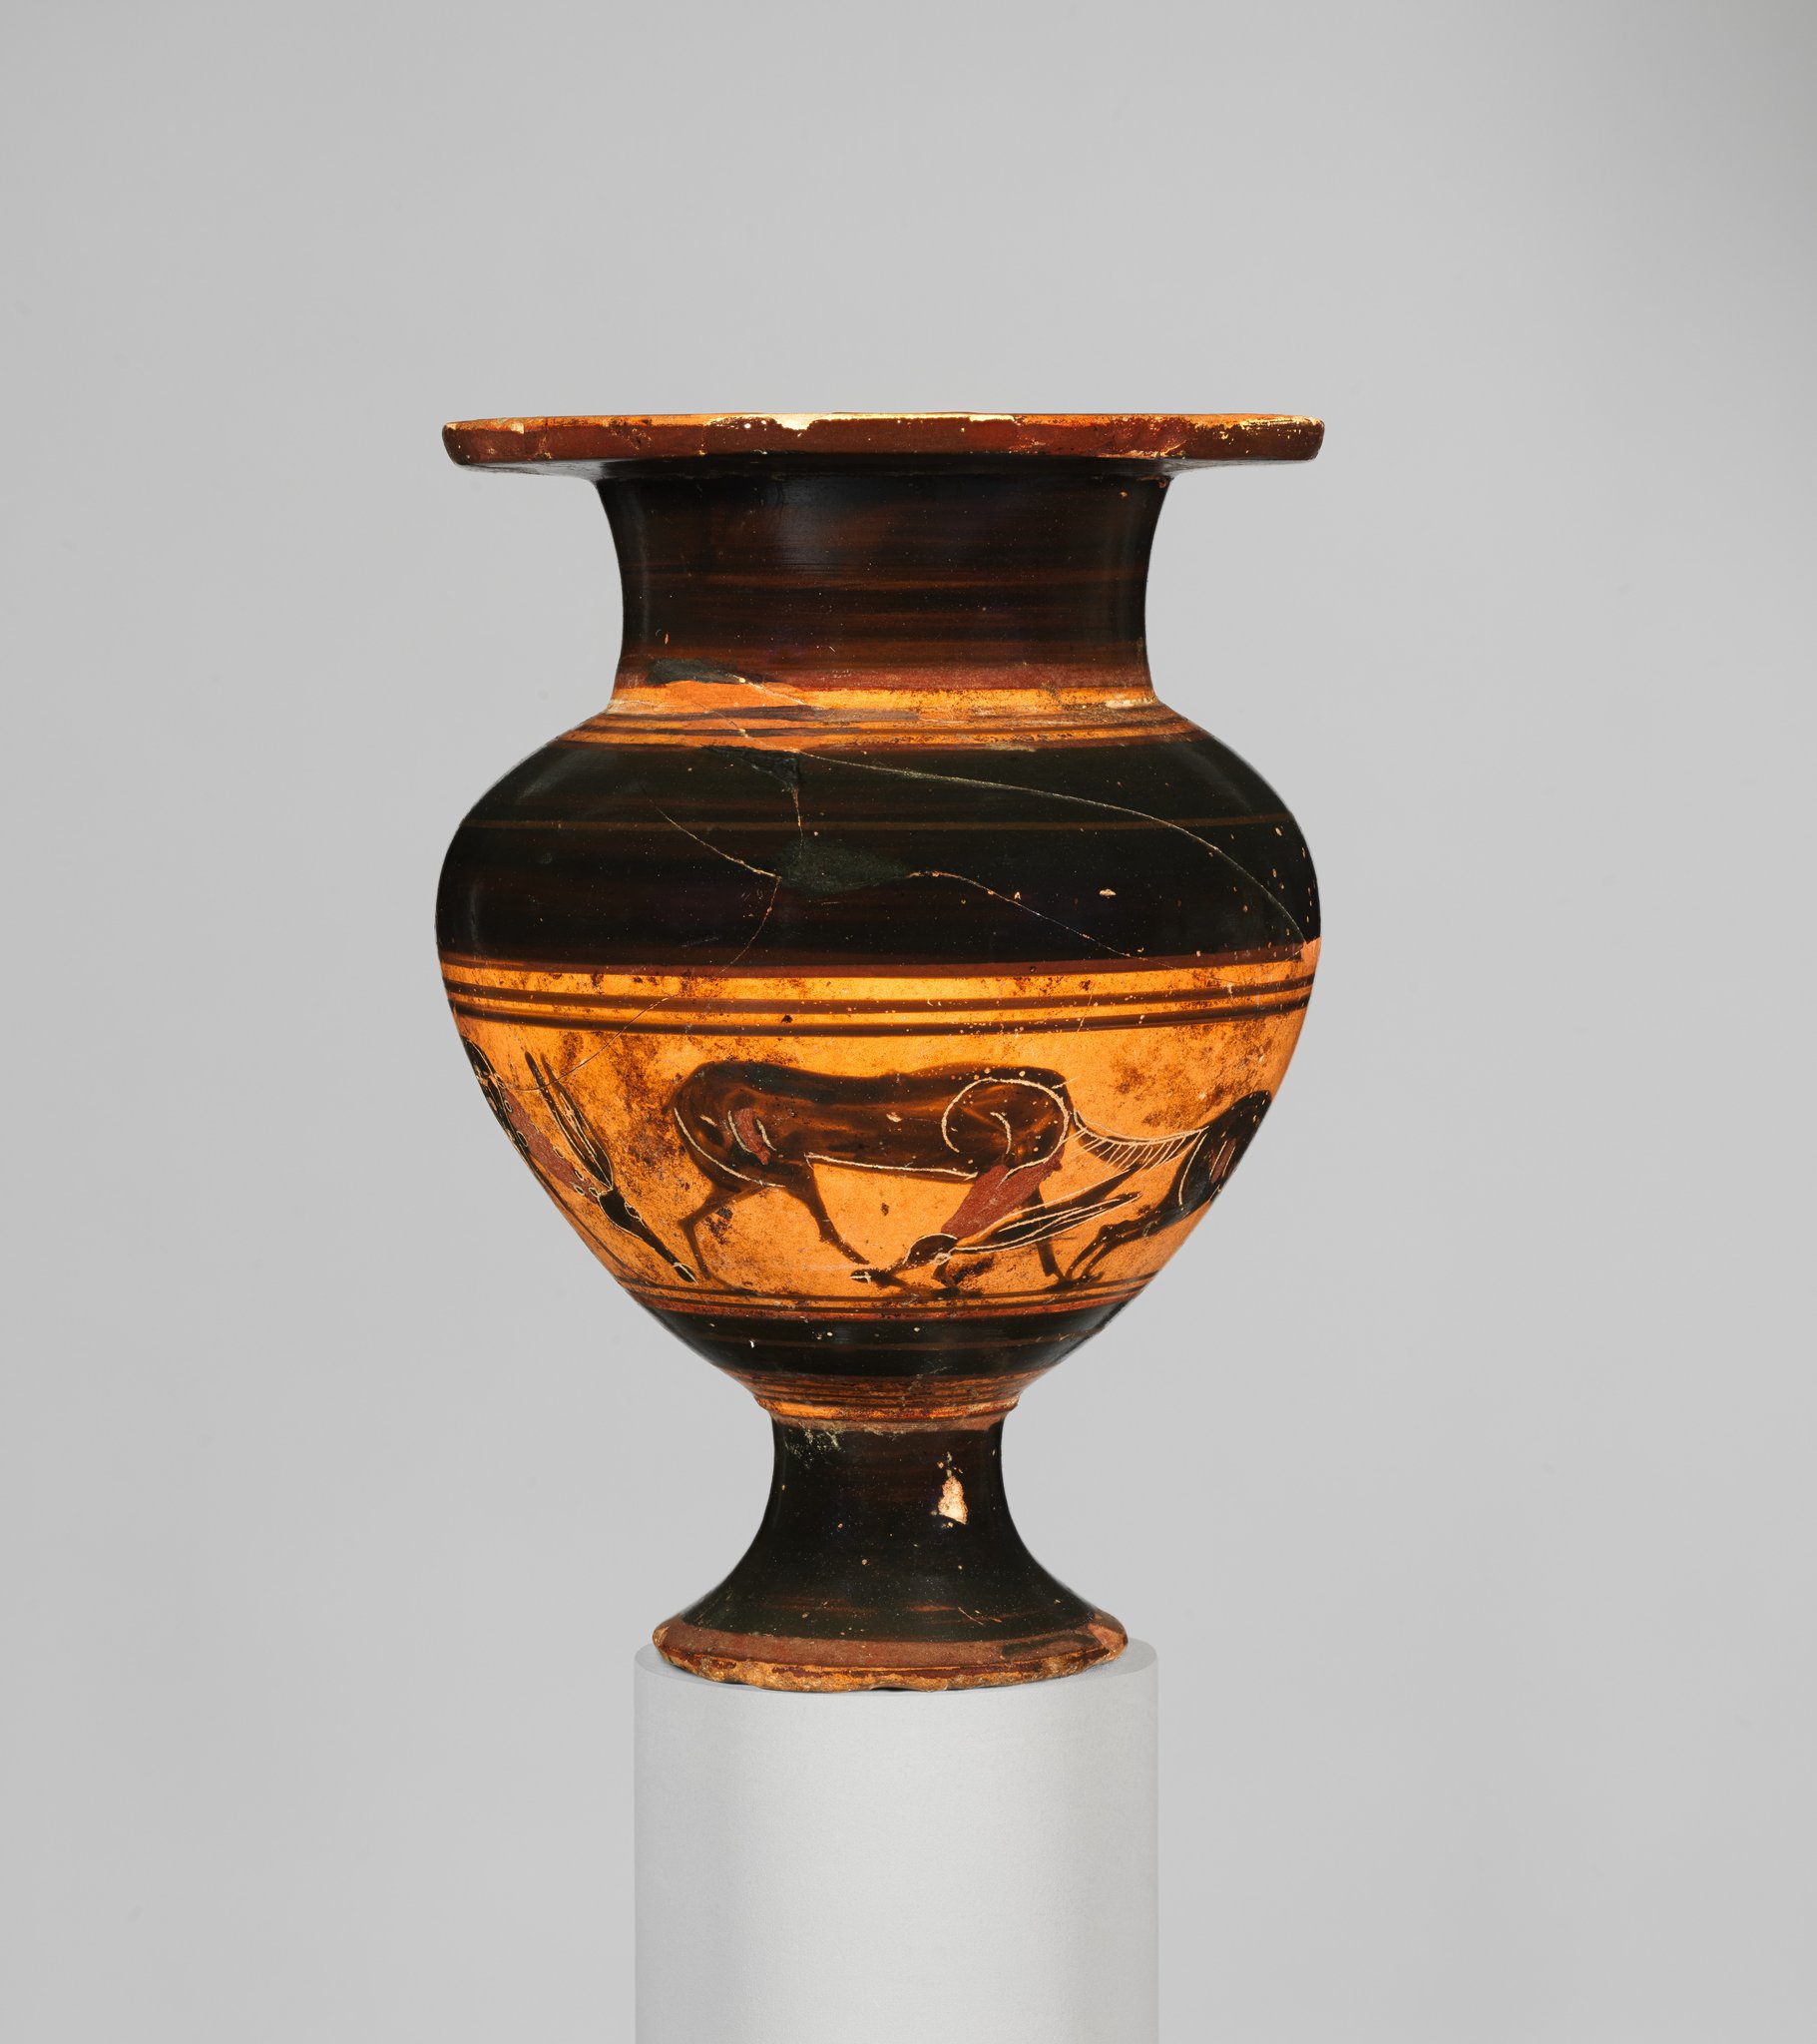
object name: lydion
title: Terracotta lydion (perfume jar)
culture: greek, attic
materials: terracotta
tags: animals